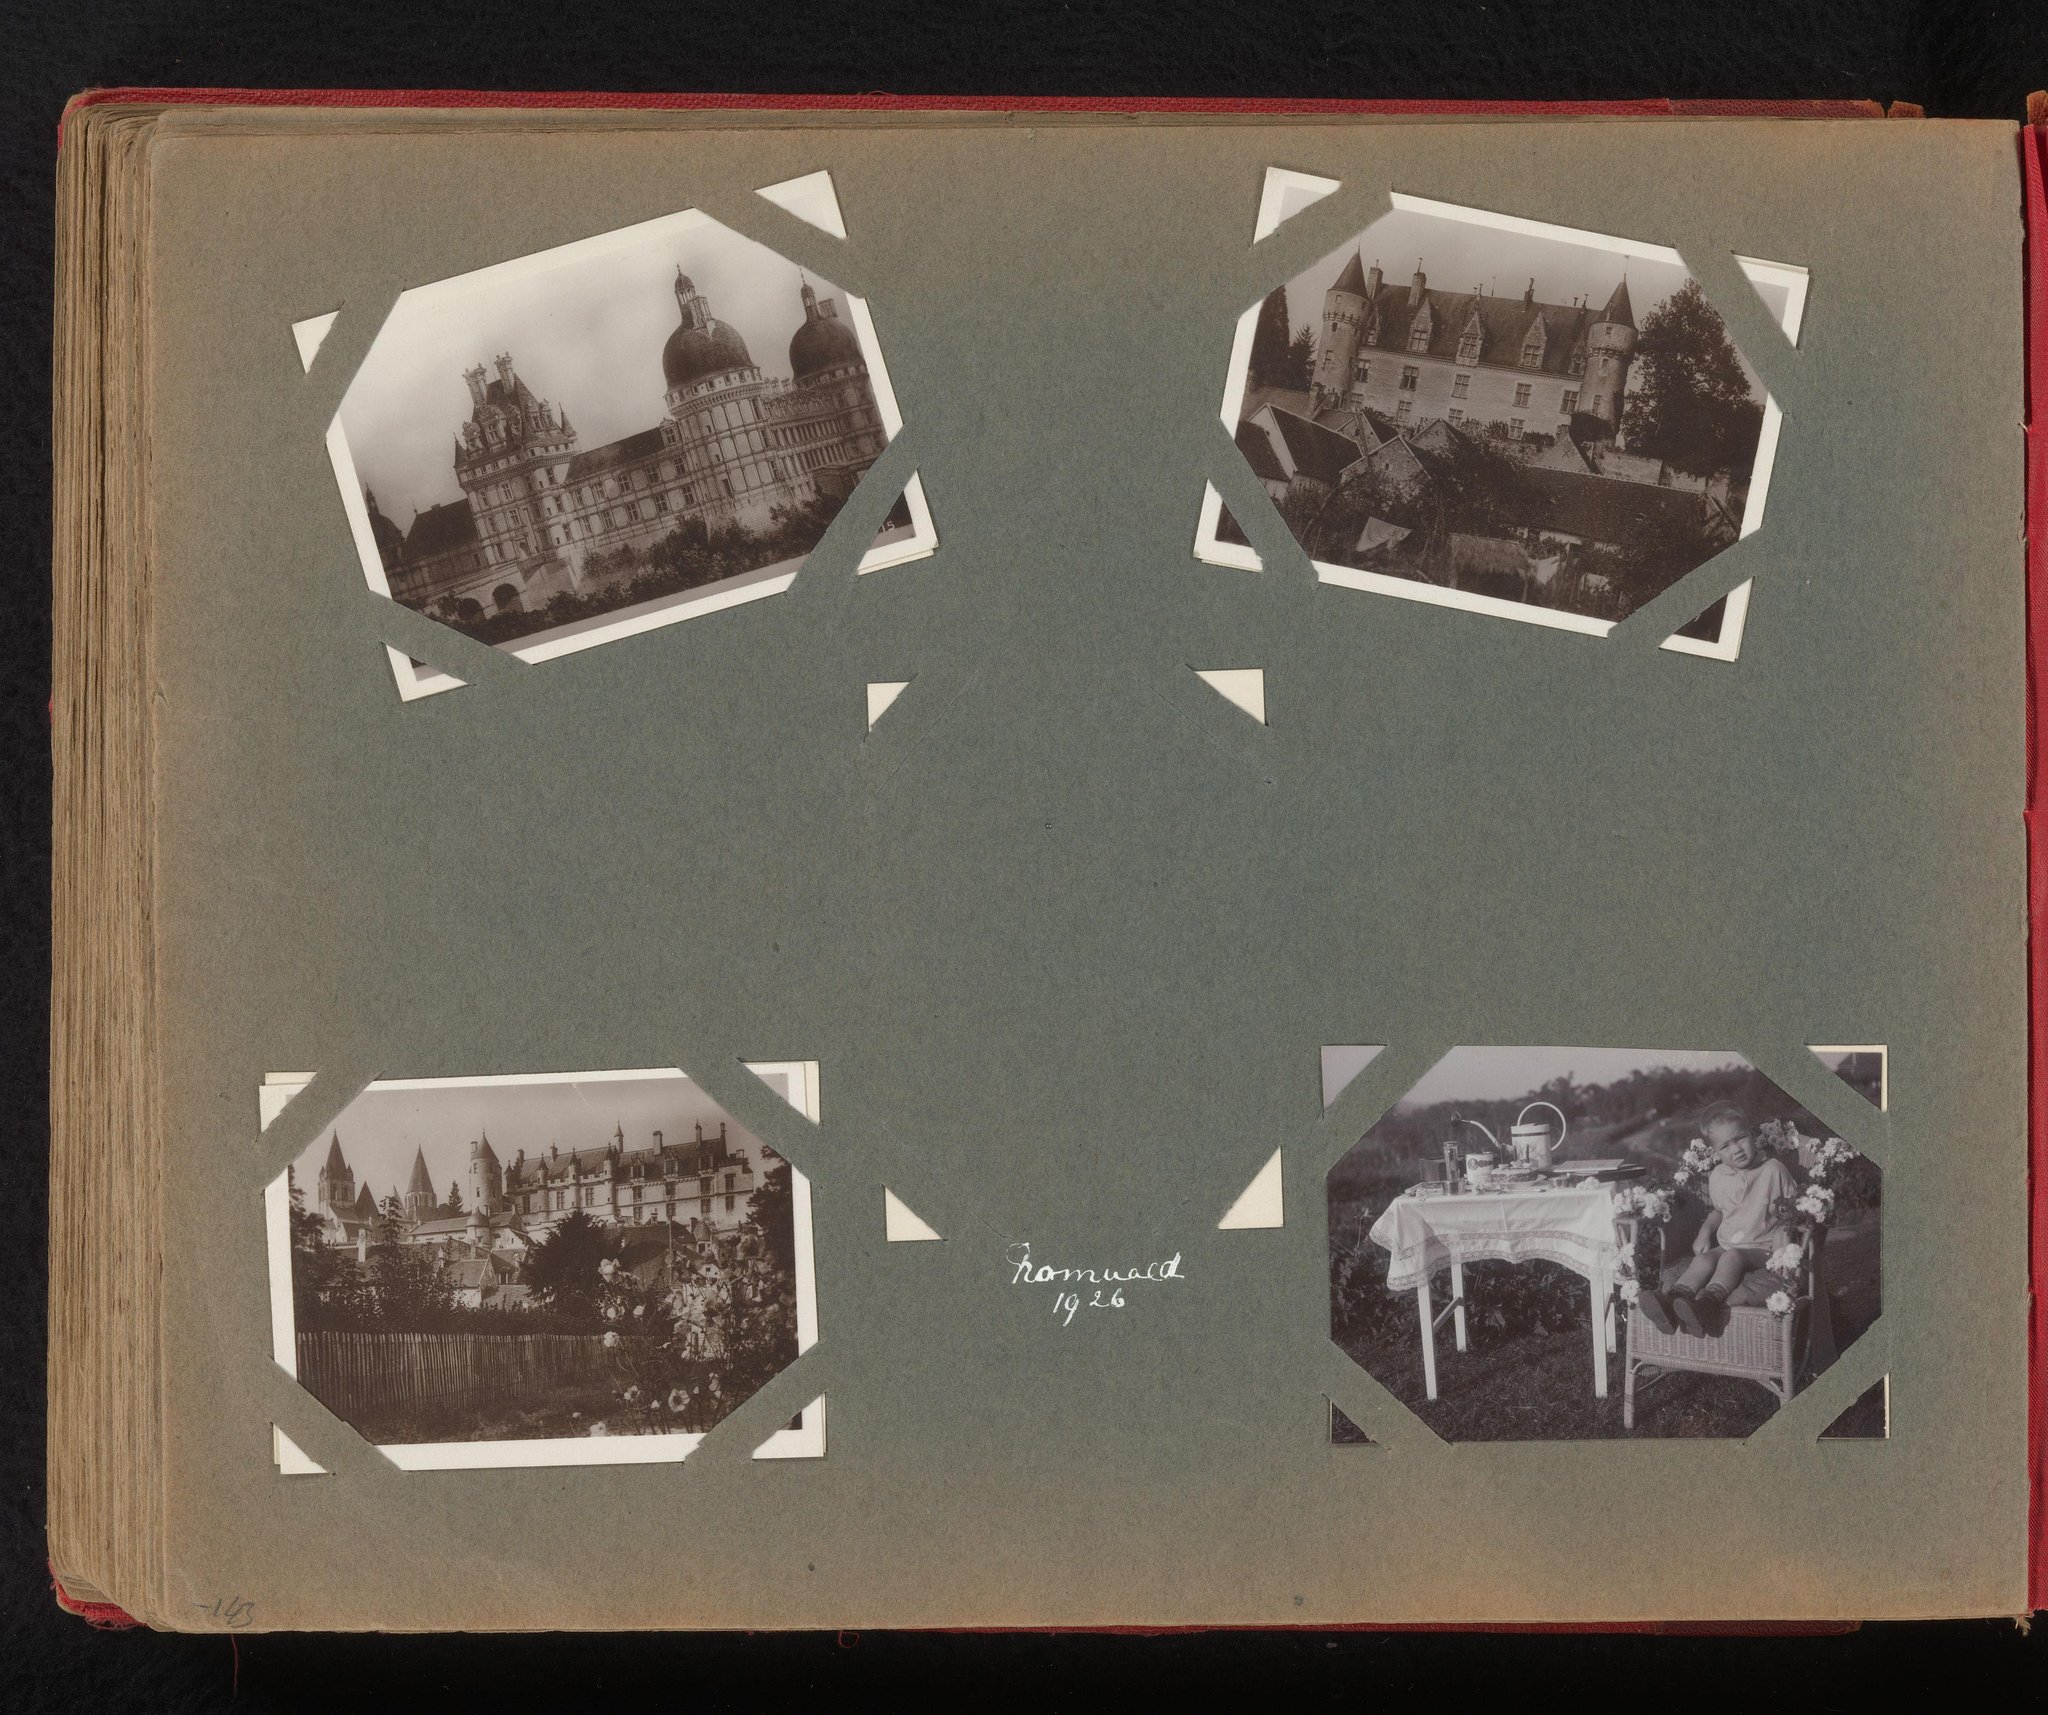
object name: album leaf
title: Gezichten op drie Franse kastelen en Romuald Boelen bij een gedekte tafel in een tuin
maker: Anonymous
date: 1905-1926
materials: paper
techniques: gelatin silver print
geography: france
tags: castle, france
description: Groot Plattenberg was eigendom van Jacob Theodorus (Co) Boelen.